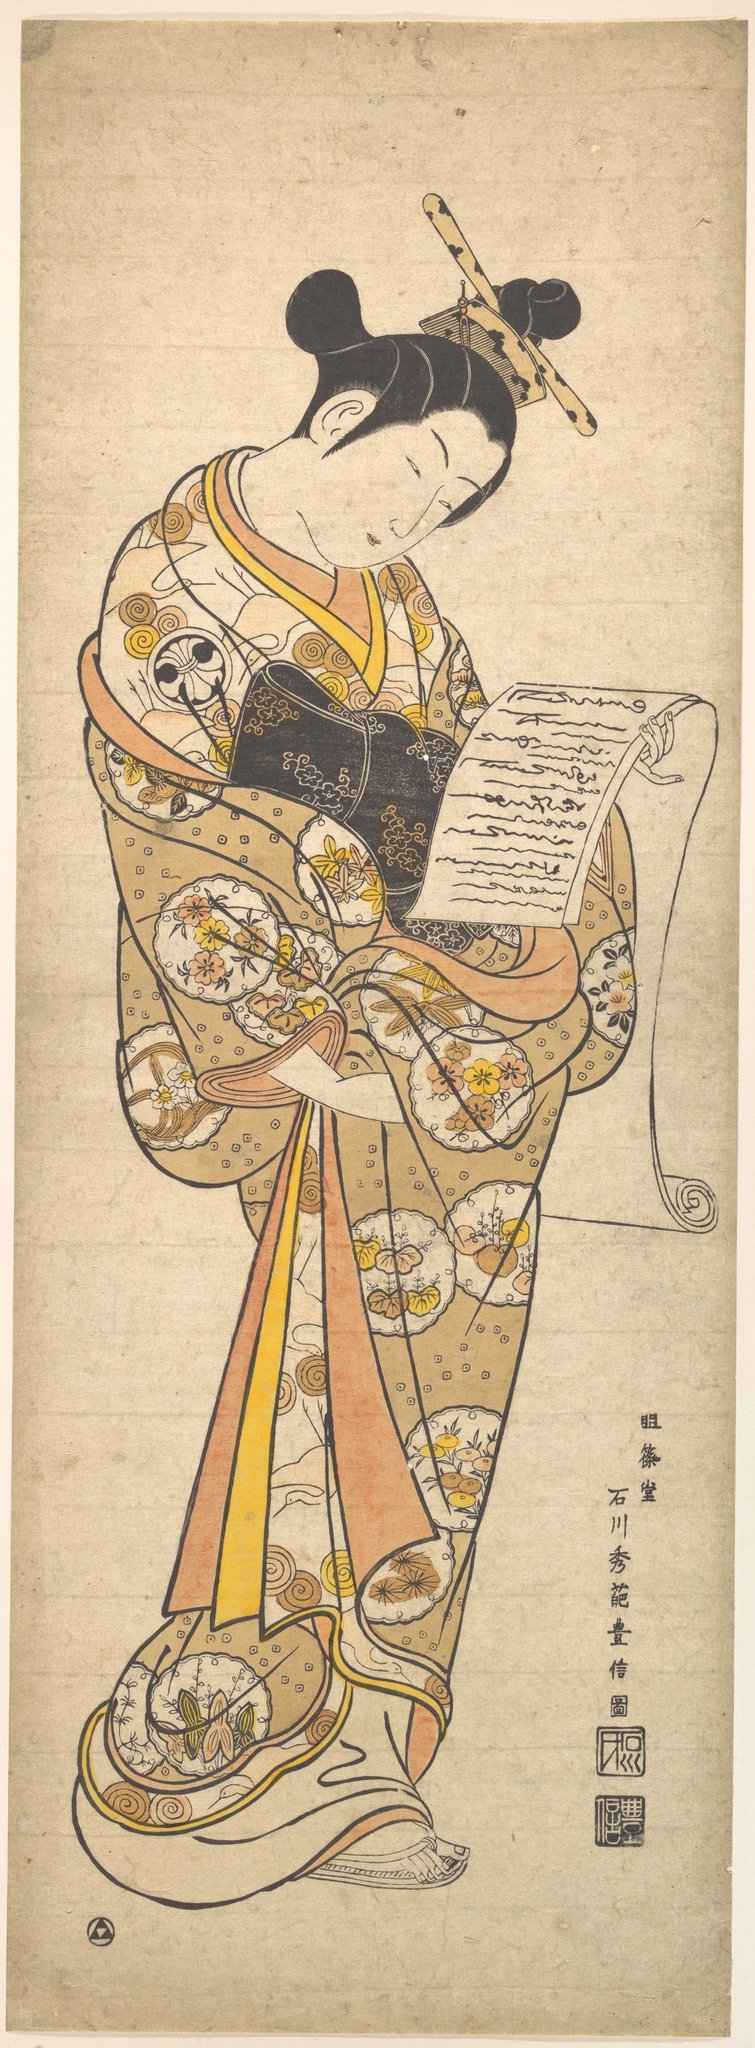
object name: print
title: The Kabuki Actor Segawa Kikunojo in the Role of a Courtesan Reading a Letter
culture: japanese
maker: ishikawa toyonobu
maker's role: artist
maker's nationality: japanese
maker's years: 1711-1785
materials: ink, paper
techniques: woodblock print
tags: women,reading,actors